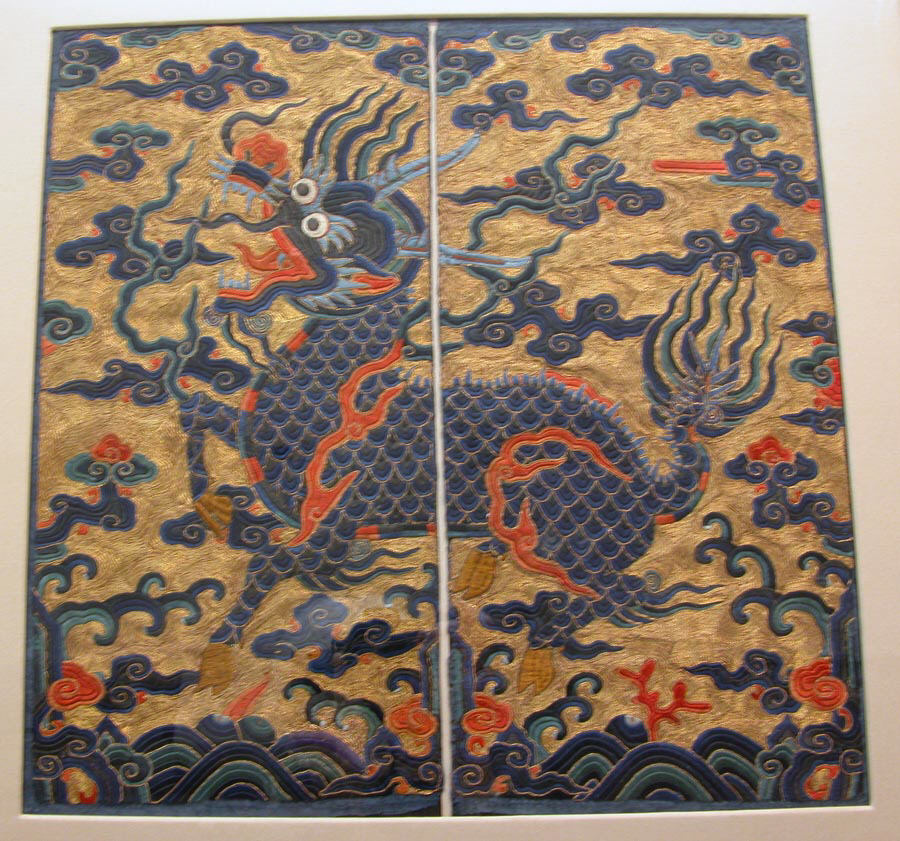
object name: rank badge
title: Rank Badge with Qilin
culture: chinese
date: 1667-1700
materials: textile, metal thread, silk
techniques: embroidery, weave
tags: mythical creatures